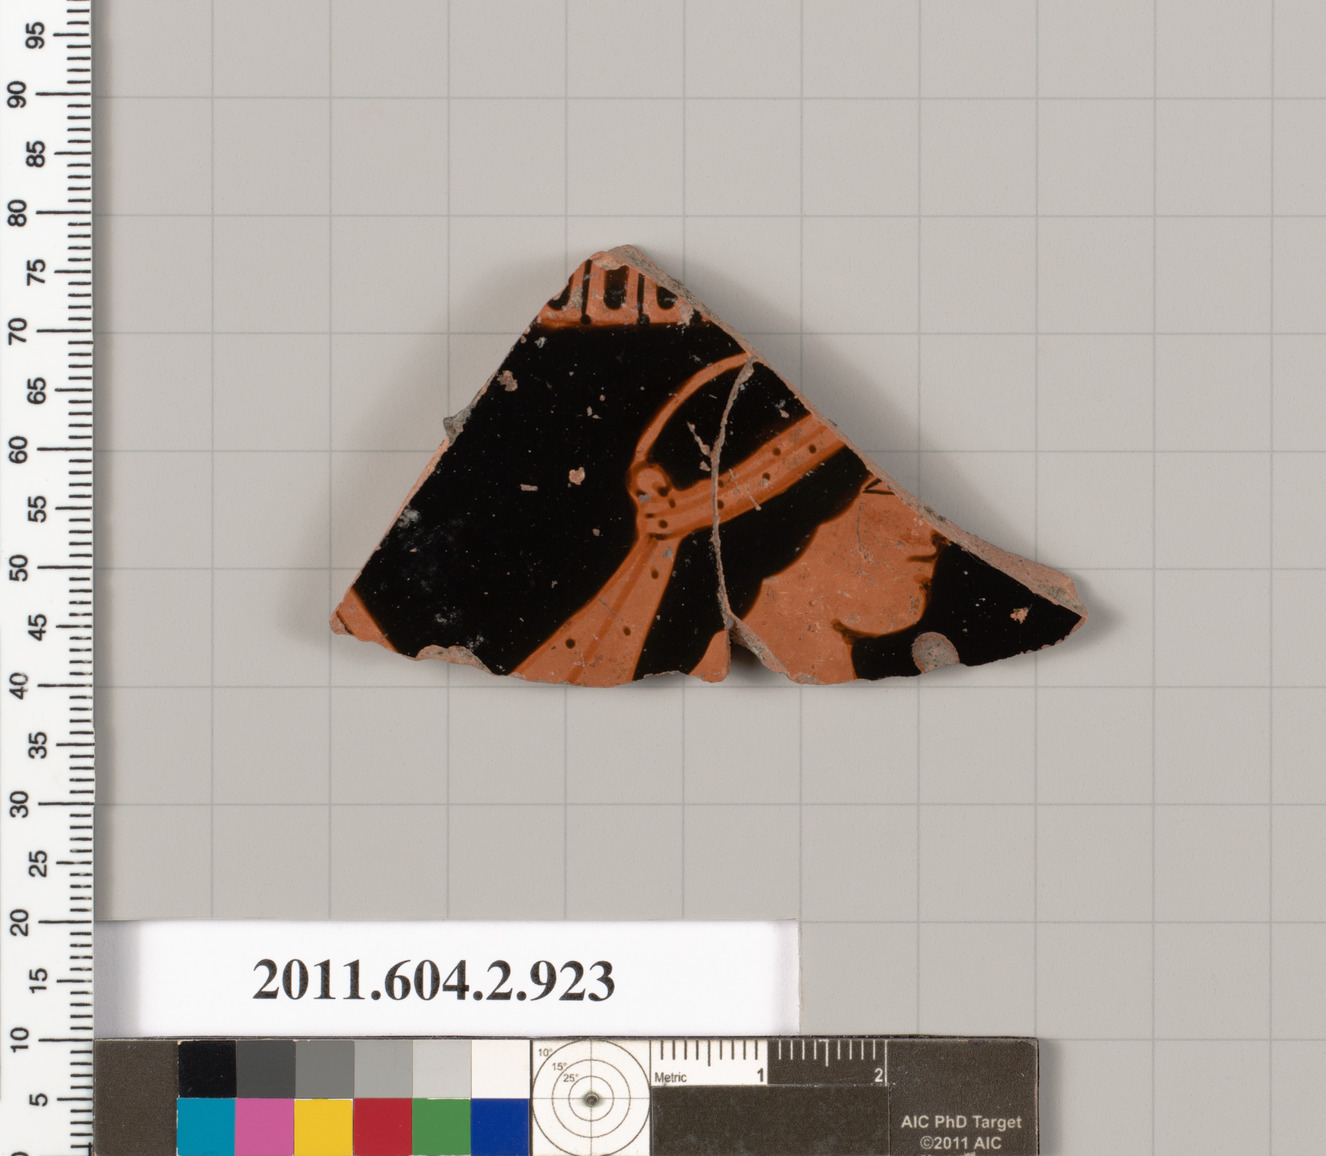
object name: kalpis fragment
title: Terracotta fragment of a hydria: kalpis (water jar)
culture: greek, attic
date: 460-450 BCE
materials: terracotta